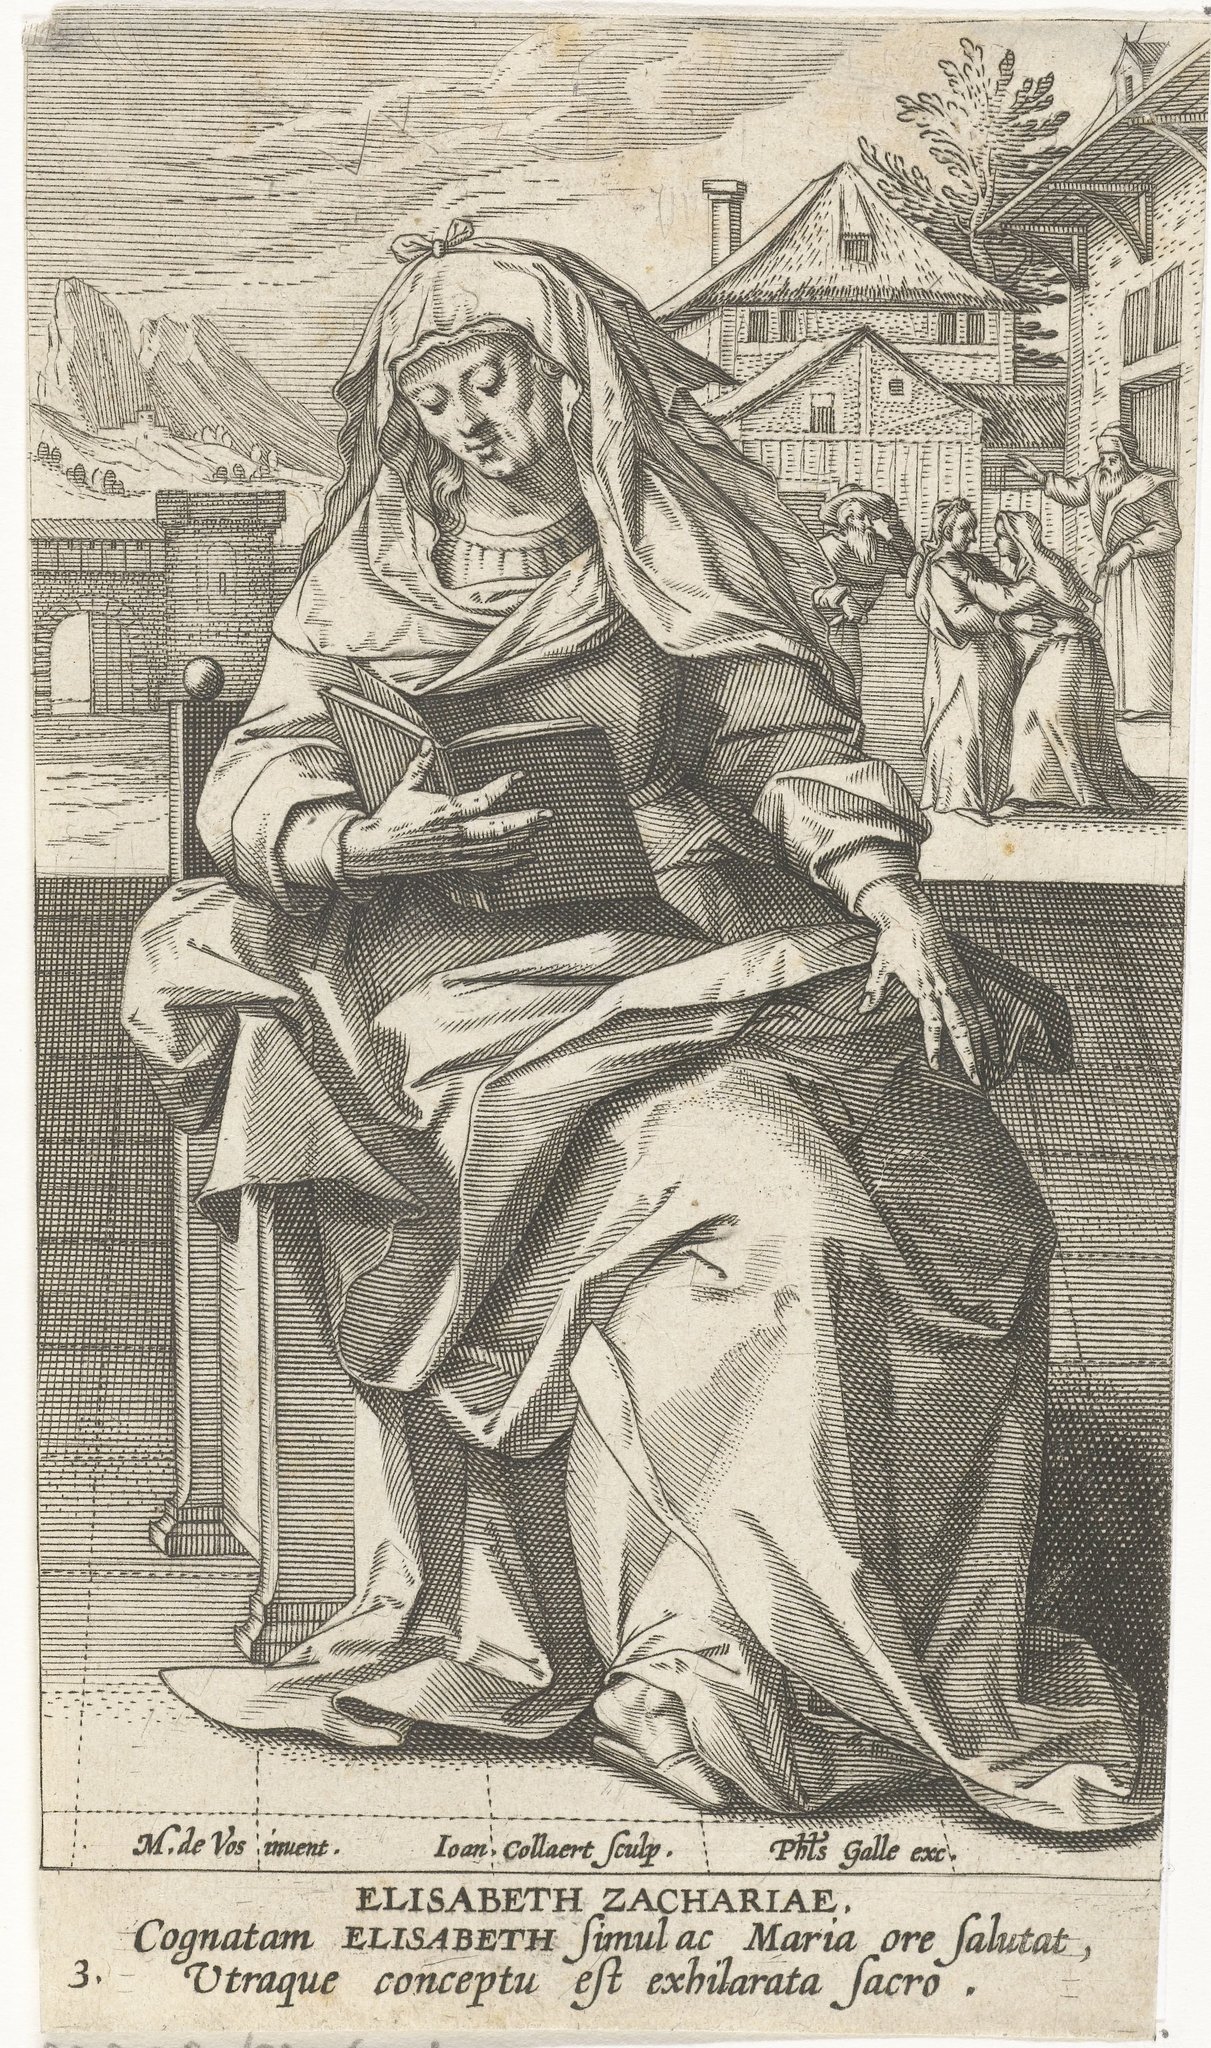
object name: print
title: Heilige Elisabet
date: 1595-1599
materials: paper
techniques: engraving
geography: antwerp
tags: mary and elisabeth, both pregnant, embracing, elisabeth, mother of john the baptist; possible attributes: john the baptist as child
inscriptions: collector's mark: Lugt 2228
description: Op de voorgrond Elisabet, moeder van Johannes de Doper, lezend op een stoel. Op de achtergrond de ontmoeting tussen Elisabet en Maria. De prent heeft een Latijns onderschrift en maakt deel uit van een prentserie met beroemde vrouwen uit het Nieuwe Testament.